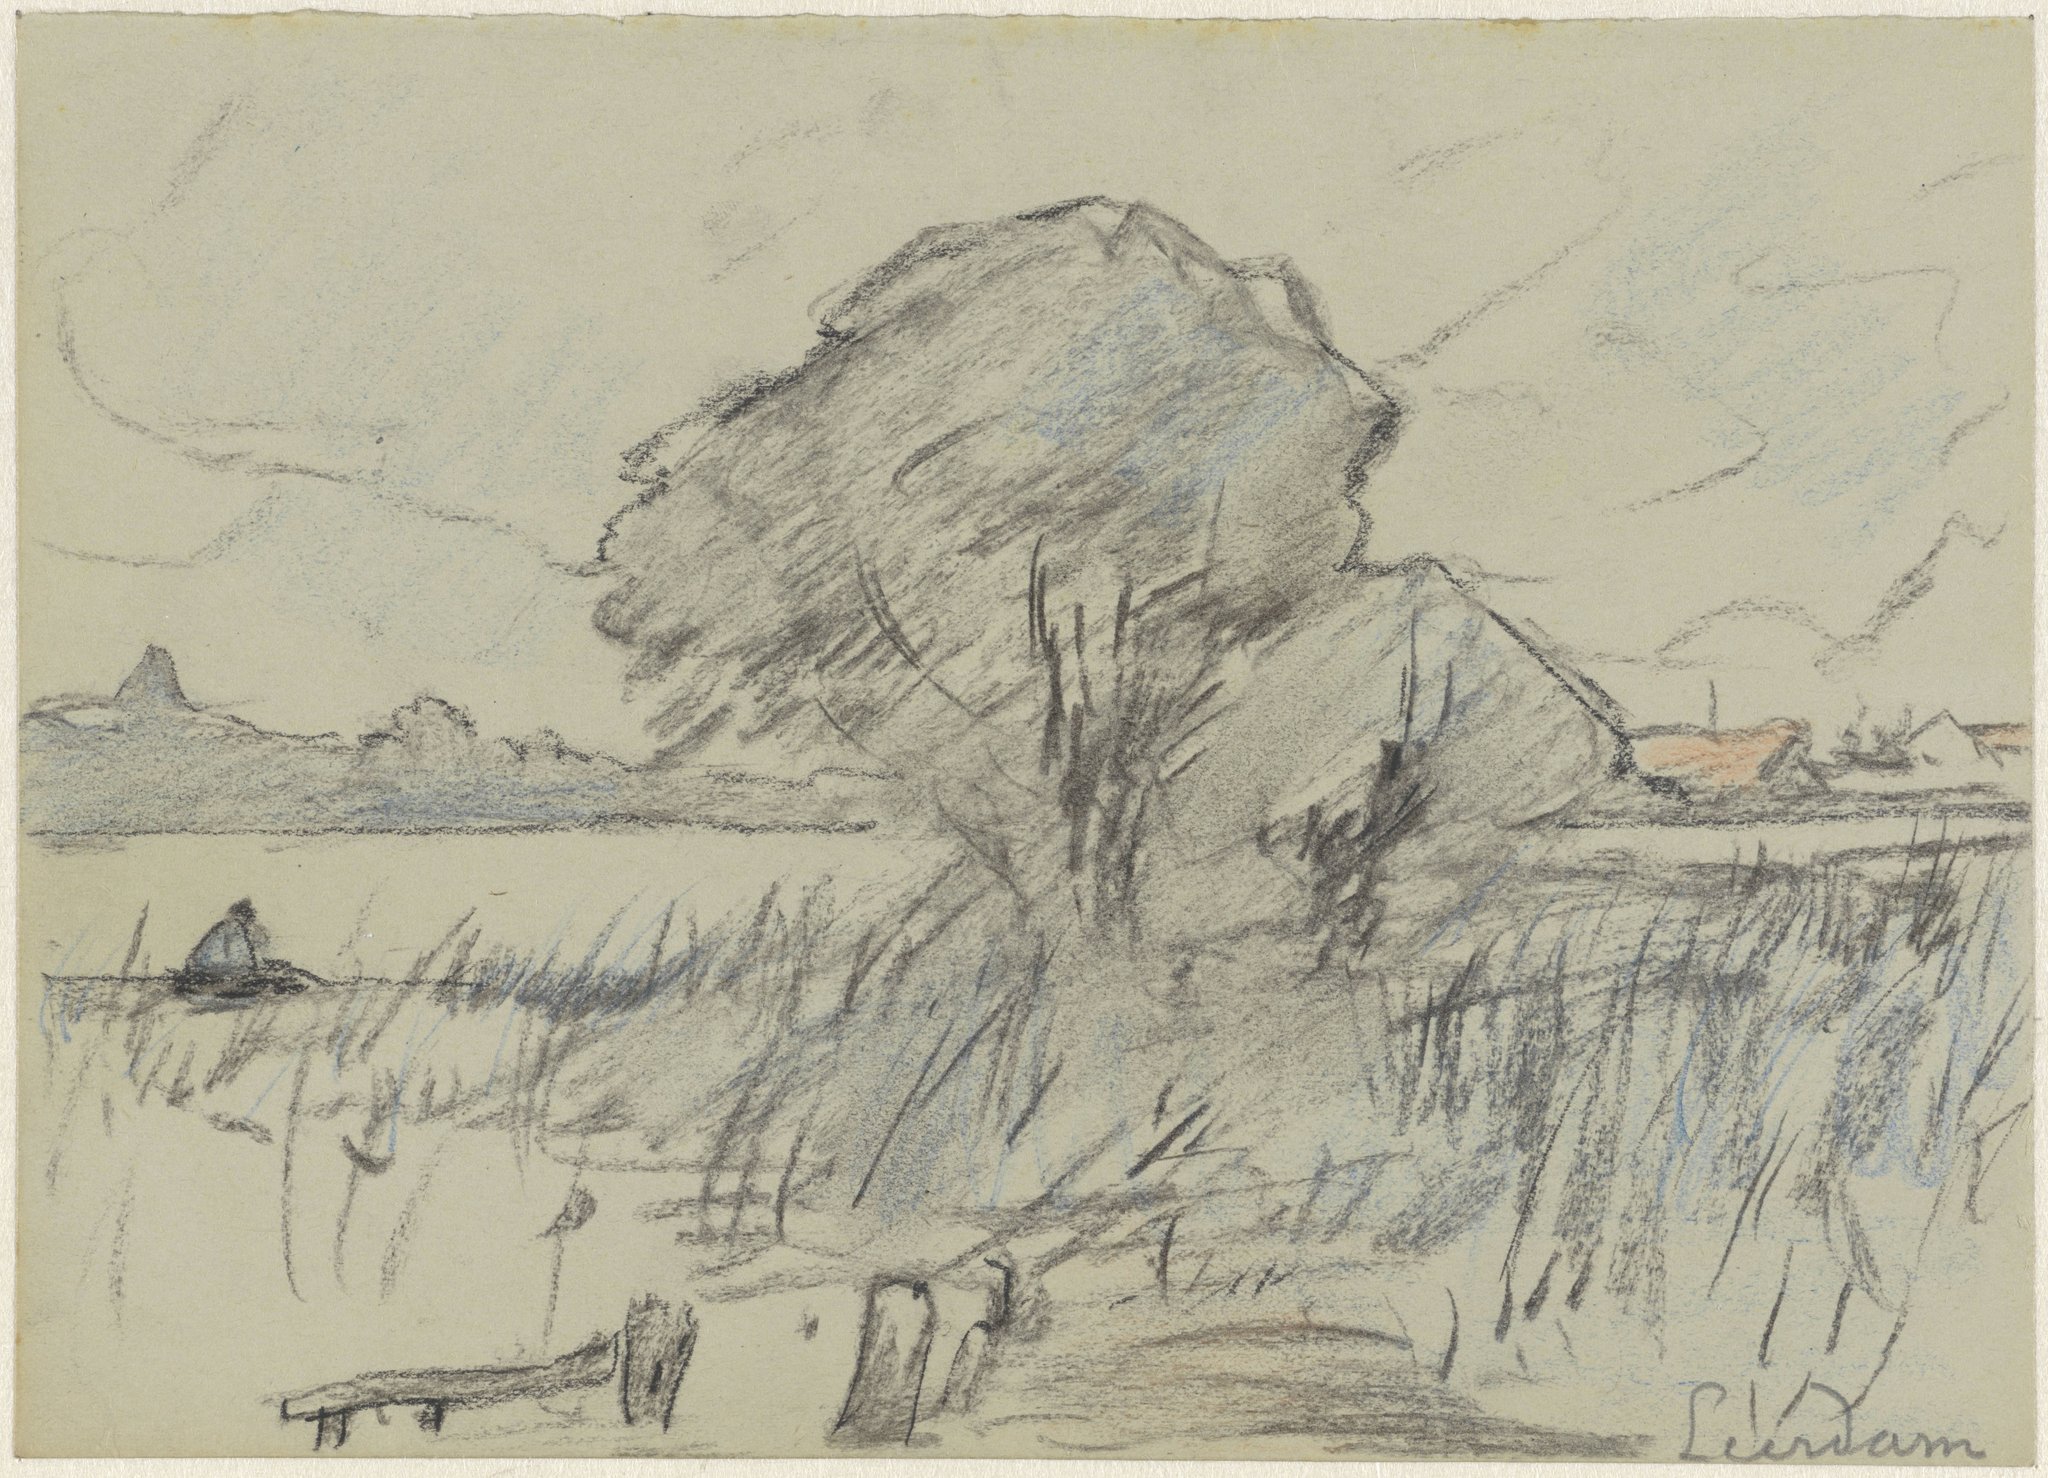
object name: drawing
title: Landschap bij Leerdam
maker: adolf le comte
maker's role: draughtsman, painter, print maker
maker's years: 1850-1921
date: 1860-1921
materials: chalk, paper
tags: landscapes in the temperate zone